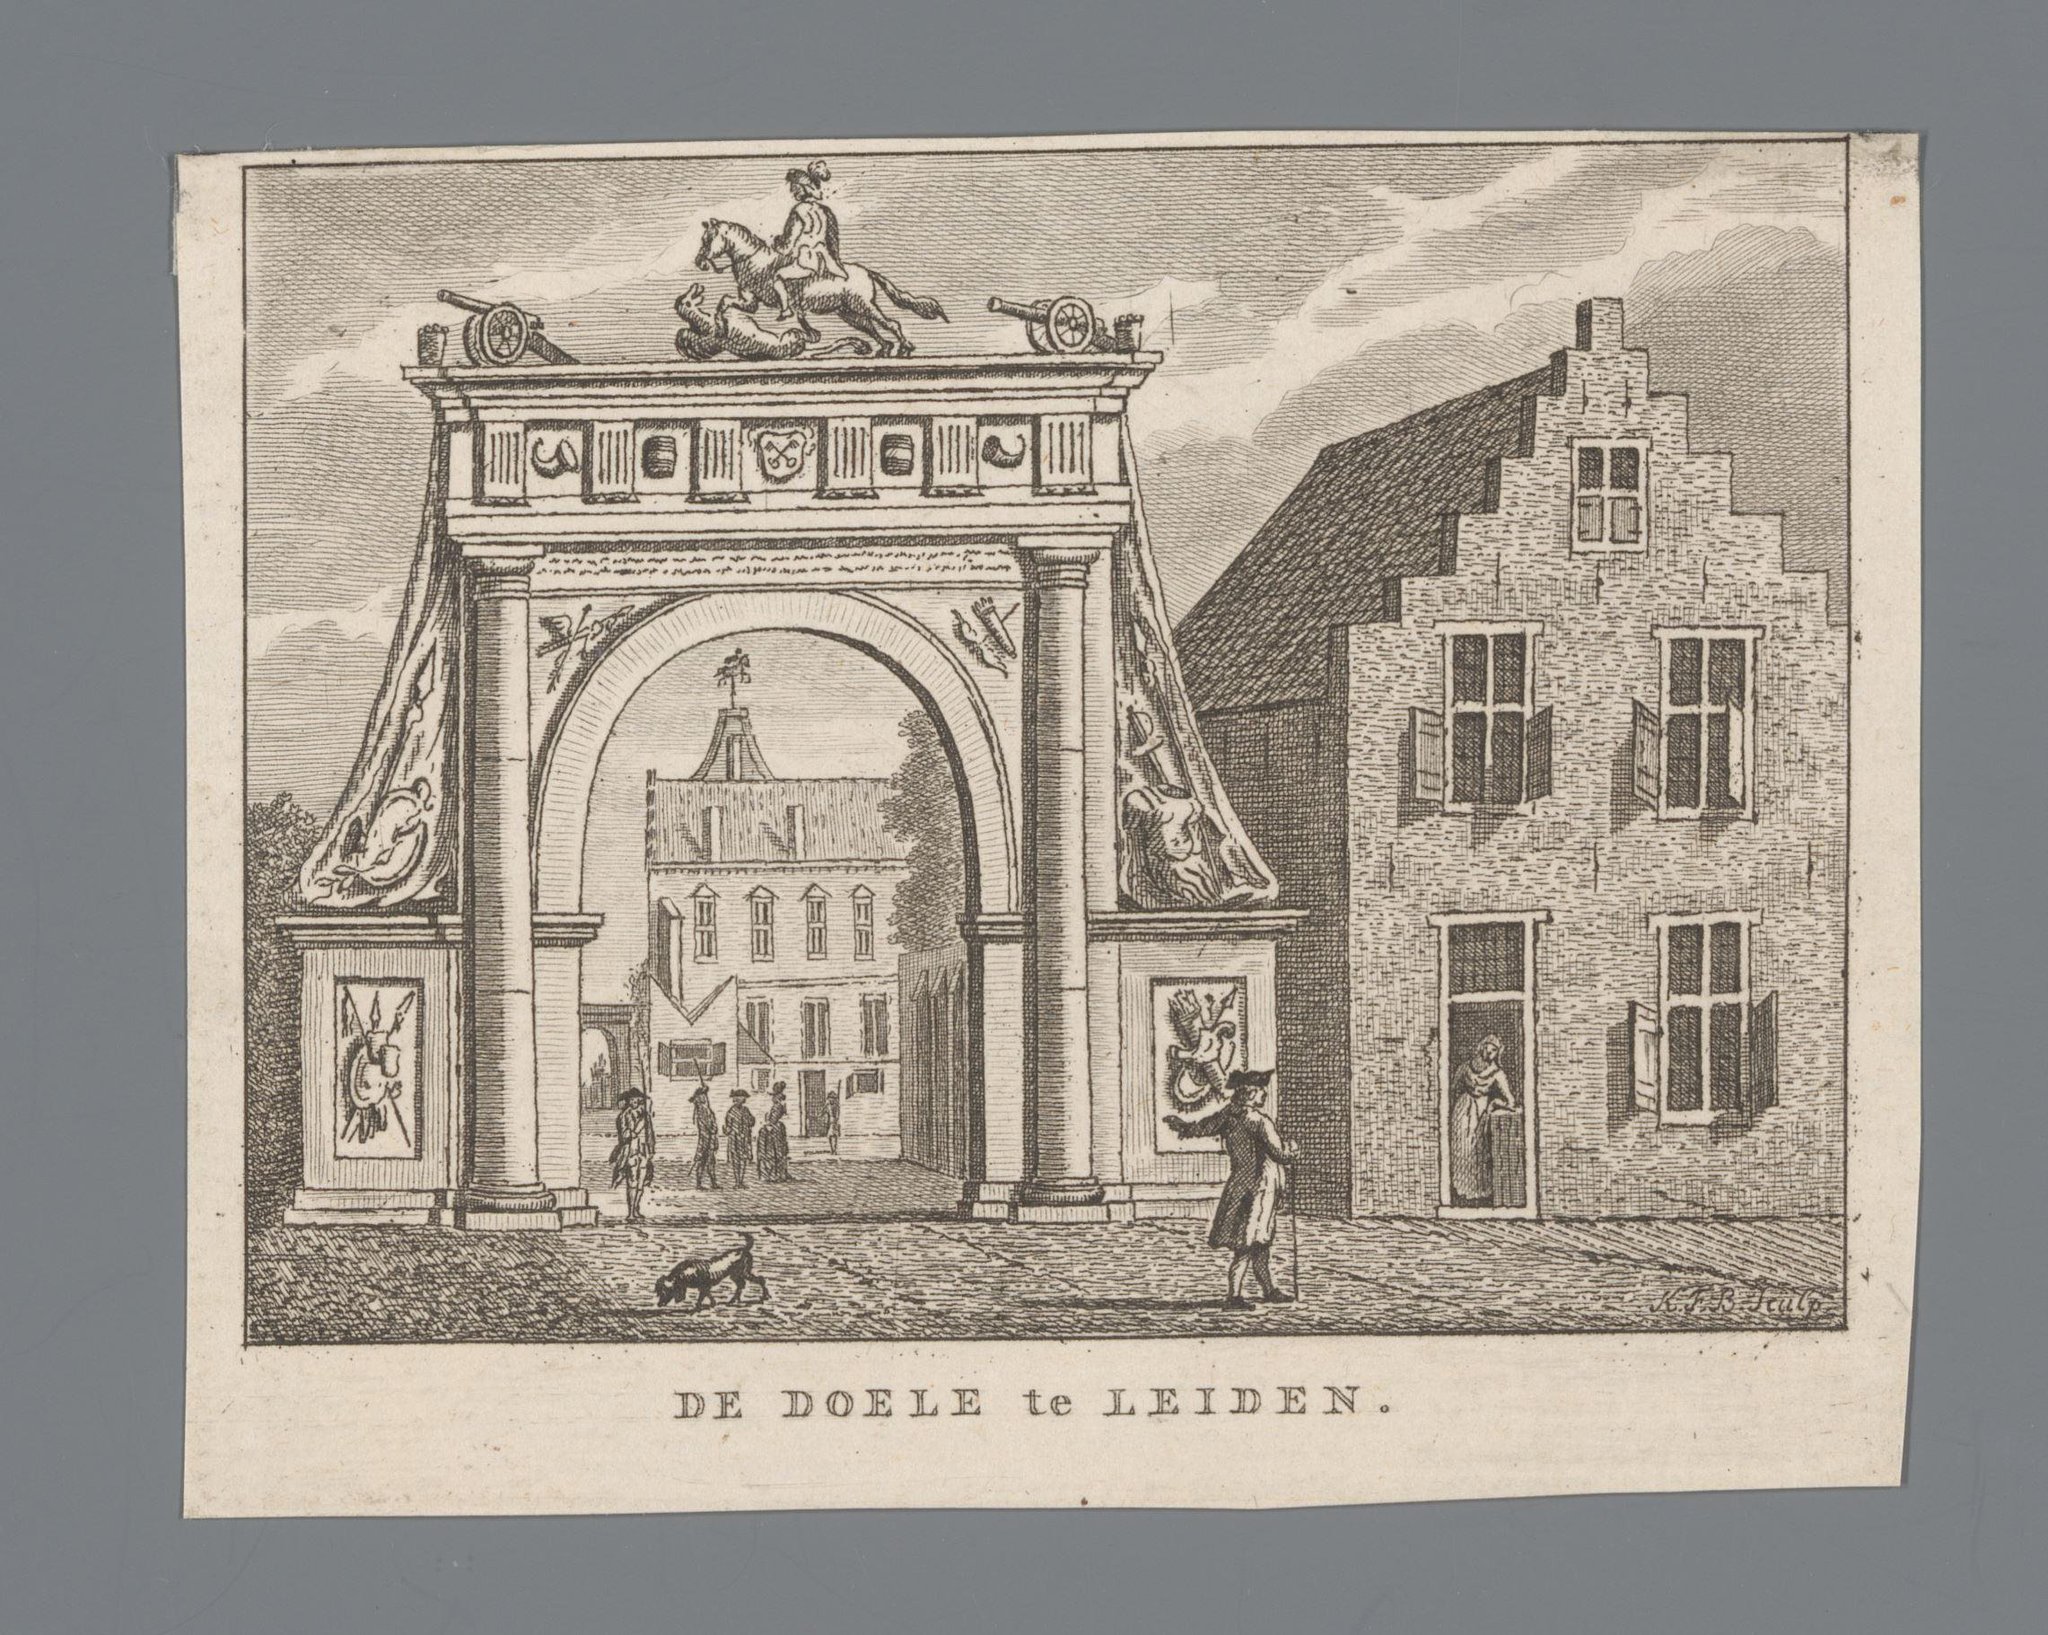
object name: print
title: De Doele te Leiden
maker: carel frederik bendorp (i)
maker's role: print maker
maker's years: 1736-1814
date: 1786-1792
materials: paper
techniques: etching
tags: gate, entrance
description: Prent uit: Vaderlandsche gezichten, of afbeeldingen van den tegenwoordigen staat der Vereenigde Nederlanden (…). Amsterdam: Hendrik Gartman, Willem Vermandel en Jan Willem Smit, 1786-1792. Uitgegeven in afleveringen met ieder een eigen bifolium en inhoudsopgave. Alle prenten in deze publicatie zijn gegraveerd door Carel Frederik Bendorp (I) en, in de meeste gevallen, gebaseerd op tekeningen van Jan Bulthuis.